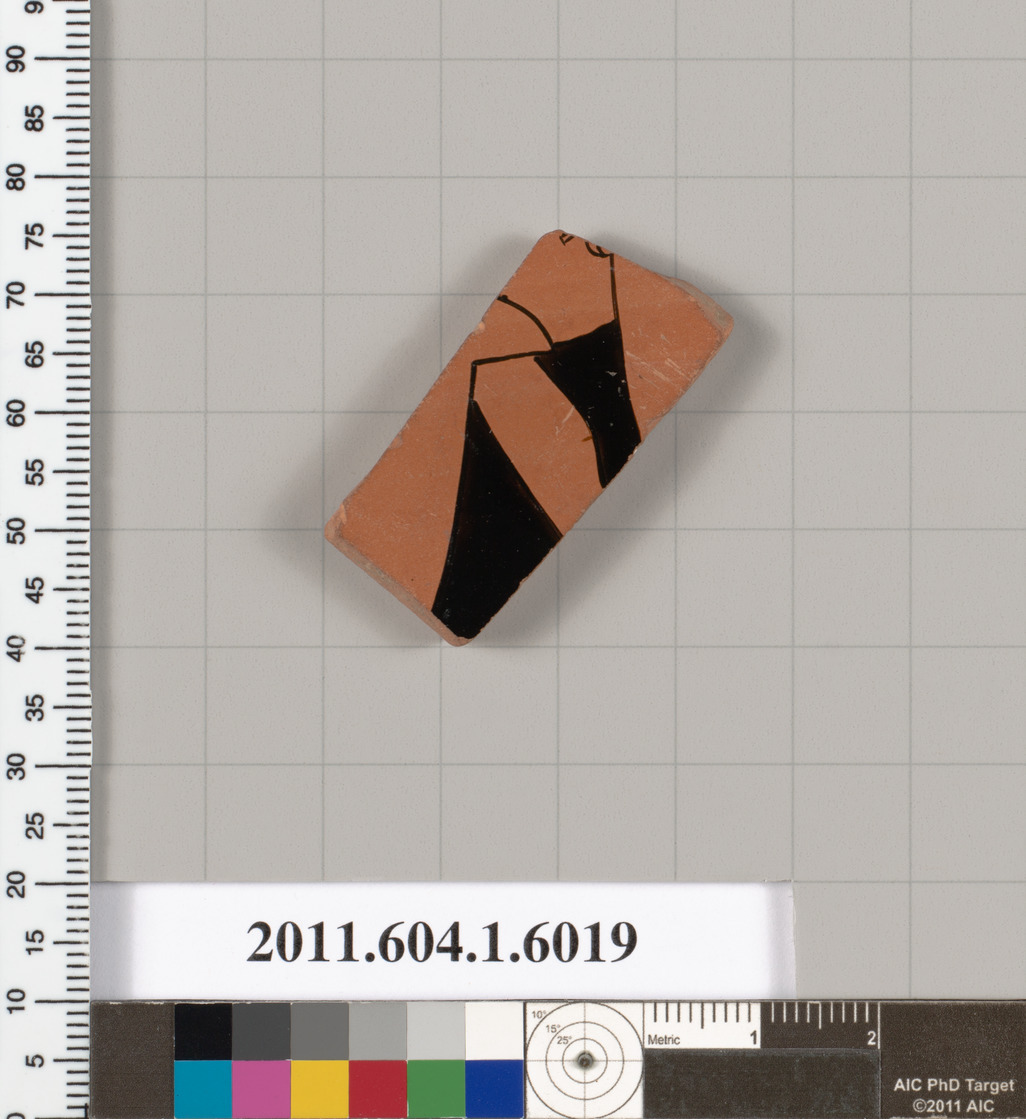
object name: kylix fragment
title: Terracotta fragment of a kylix (drinking cup)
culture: greek, attic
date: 510-500 BCE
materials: terracotta